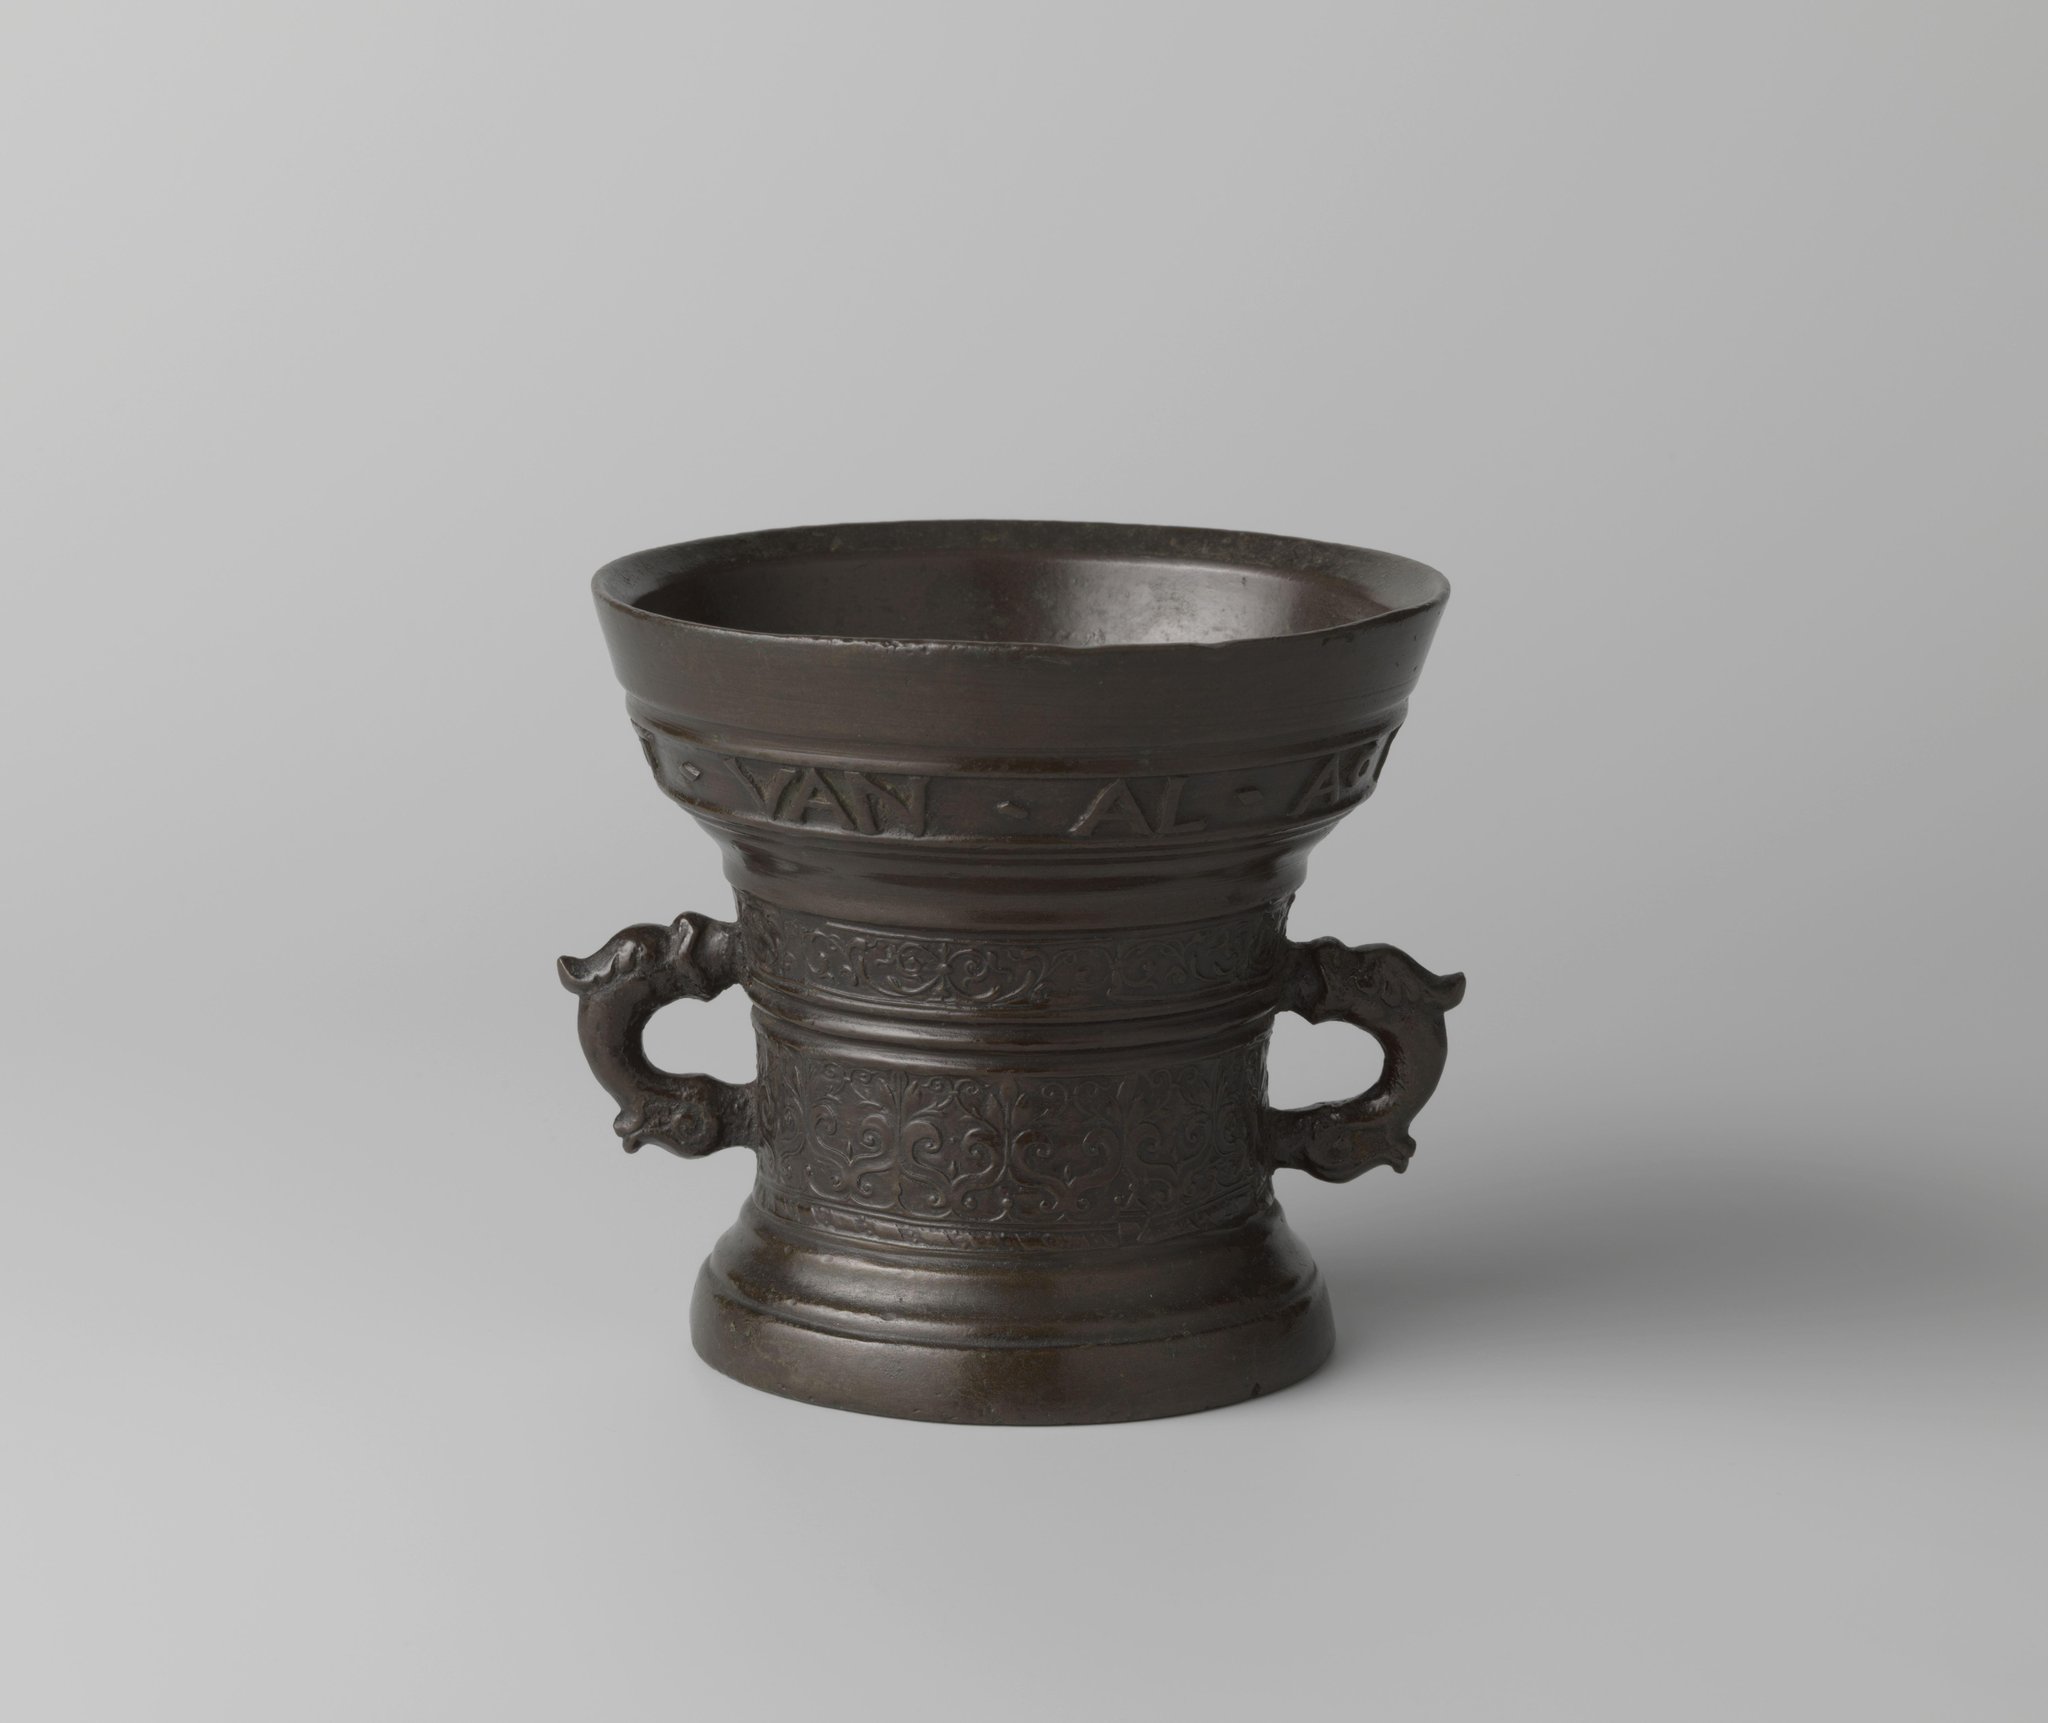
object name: mortar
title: Vijzel met opschrift: LOF GODT VAN AL AO 1622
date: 1622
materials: bronze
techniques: casting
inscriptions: inscription: ‘LOF.GODT.VAN.AL.Ao 1622.’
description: Mortar and pestle with inscription: LOF GODT VAN AL (Praise God above all) Ao 1622. Bronze. Deventer, 1622.